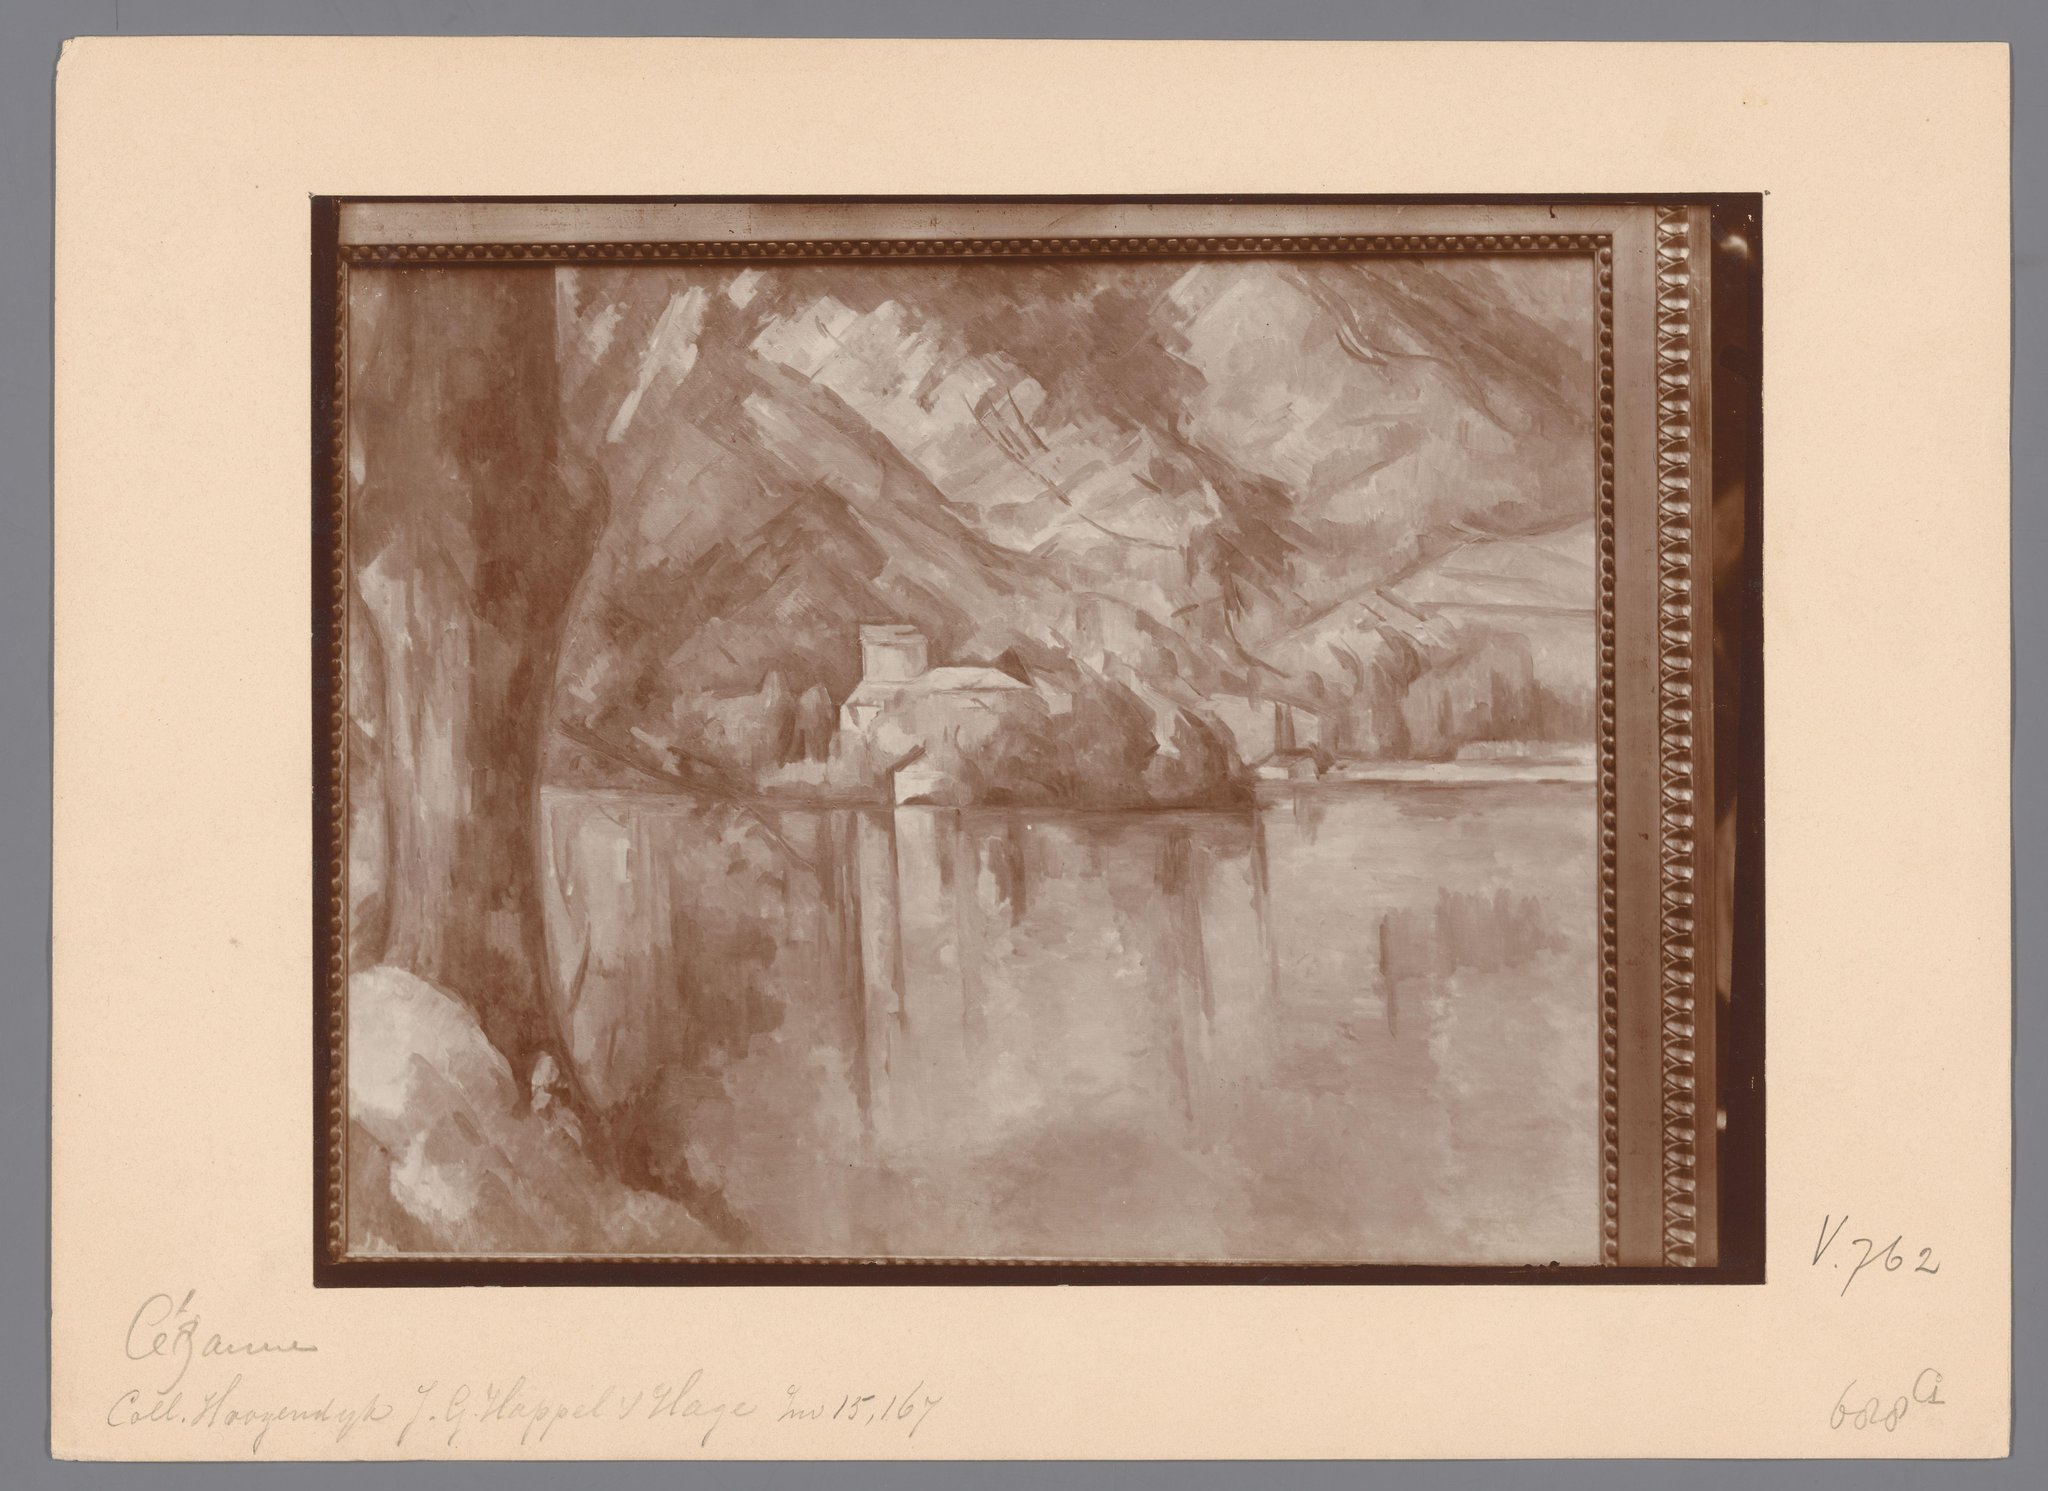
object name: photograph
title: Fotoreproductie van een schilderij met een gezicht op het meer van Annecy door Paul Cézanne uit de collectie Hoogendijk, nu in de Courtauld Gallery, Londen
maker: johannes gerardus happel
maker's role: publisher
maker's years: 1854-1928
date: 1915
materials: paper, cardboard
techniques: gelatin silver print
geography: the hague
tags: prospect of village, silhouette of village, lake, picture, painting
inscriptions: inscription: ‘1780.’, inscription: ‘V 762’, collector's mark: Lugt 2228, inscription: ‘J.P. Sprenger’, inscription: ‘Cézanne/ Coll. Hoogendijk J.G. Happel s Hage Inv 15.167/ 688G’, inscription: ‘15.167’